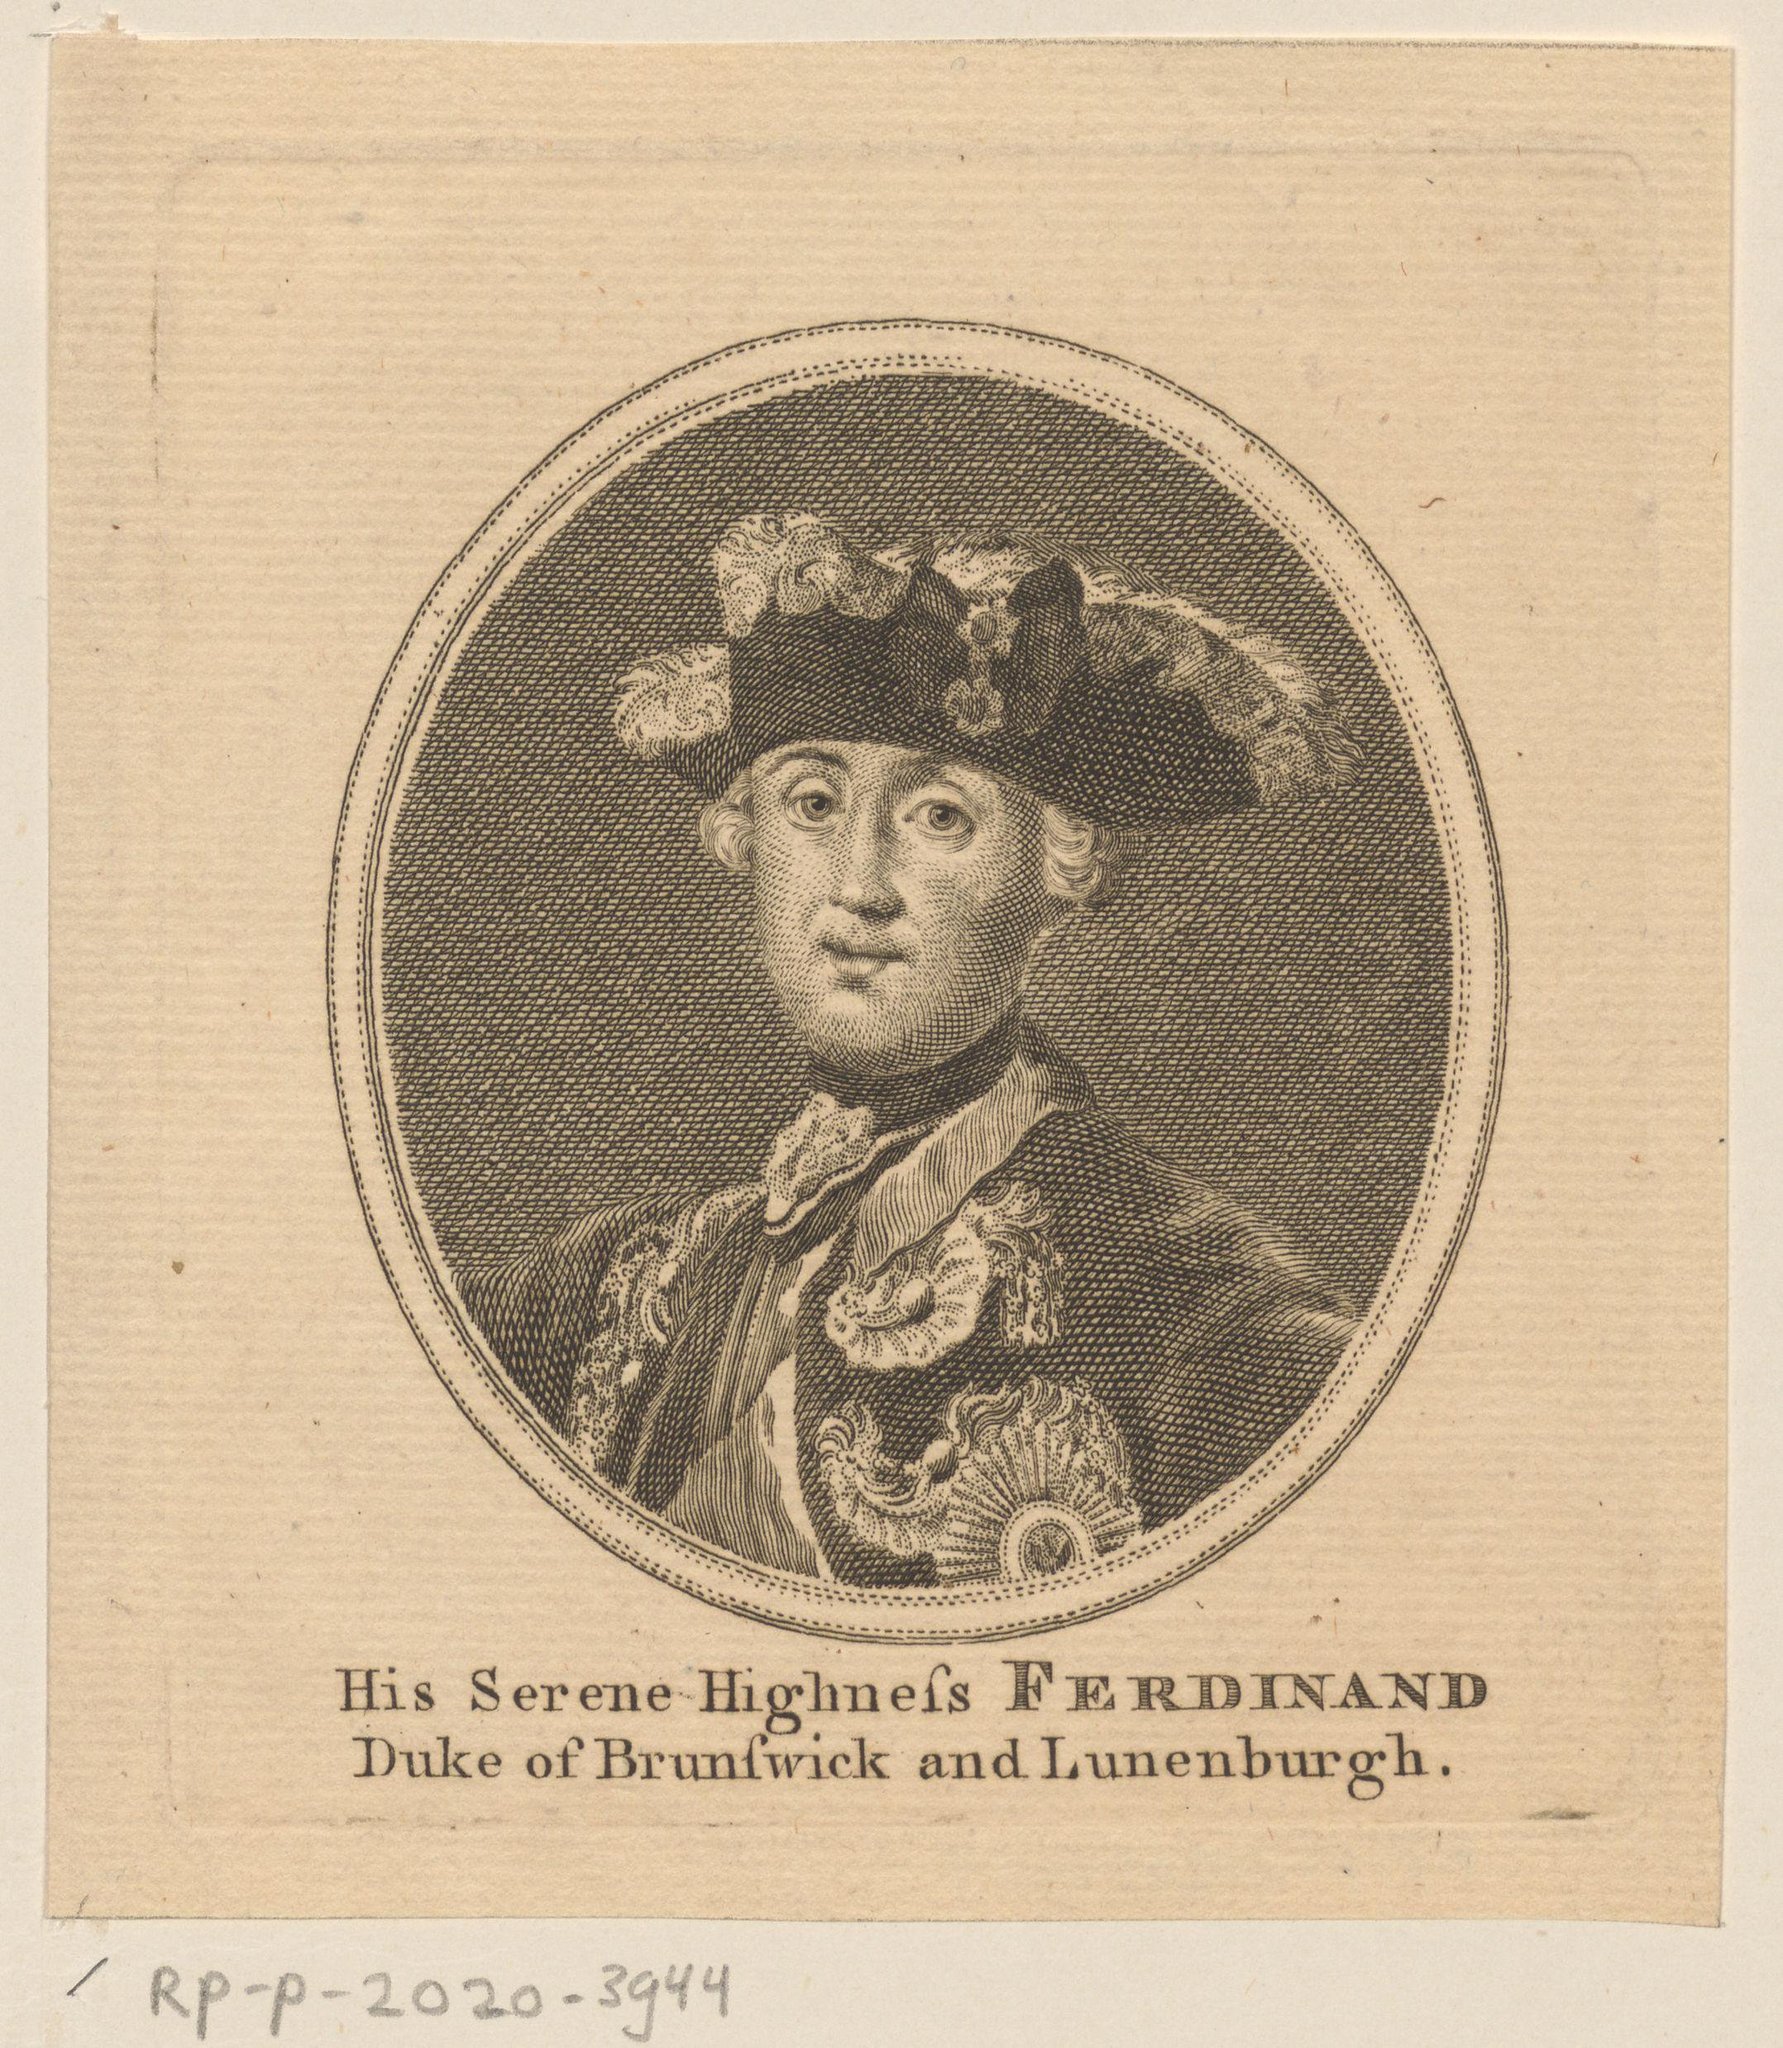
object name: print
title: Portret van Ferdinand van Brunswijk-Wolfenbüttel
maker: Anonymous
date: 1763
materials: paper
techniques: engraving, etching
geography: england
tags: commander-in-chief, general, marshal, historical persons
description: Prent waarschijnlijk uit een deel van: Entick, John. The General History of the Late War (...). Londen: Edward Dilly en John Millan, 1763-1764.